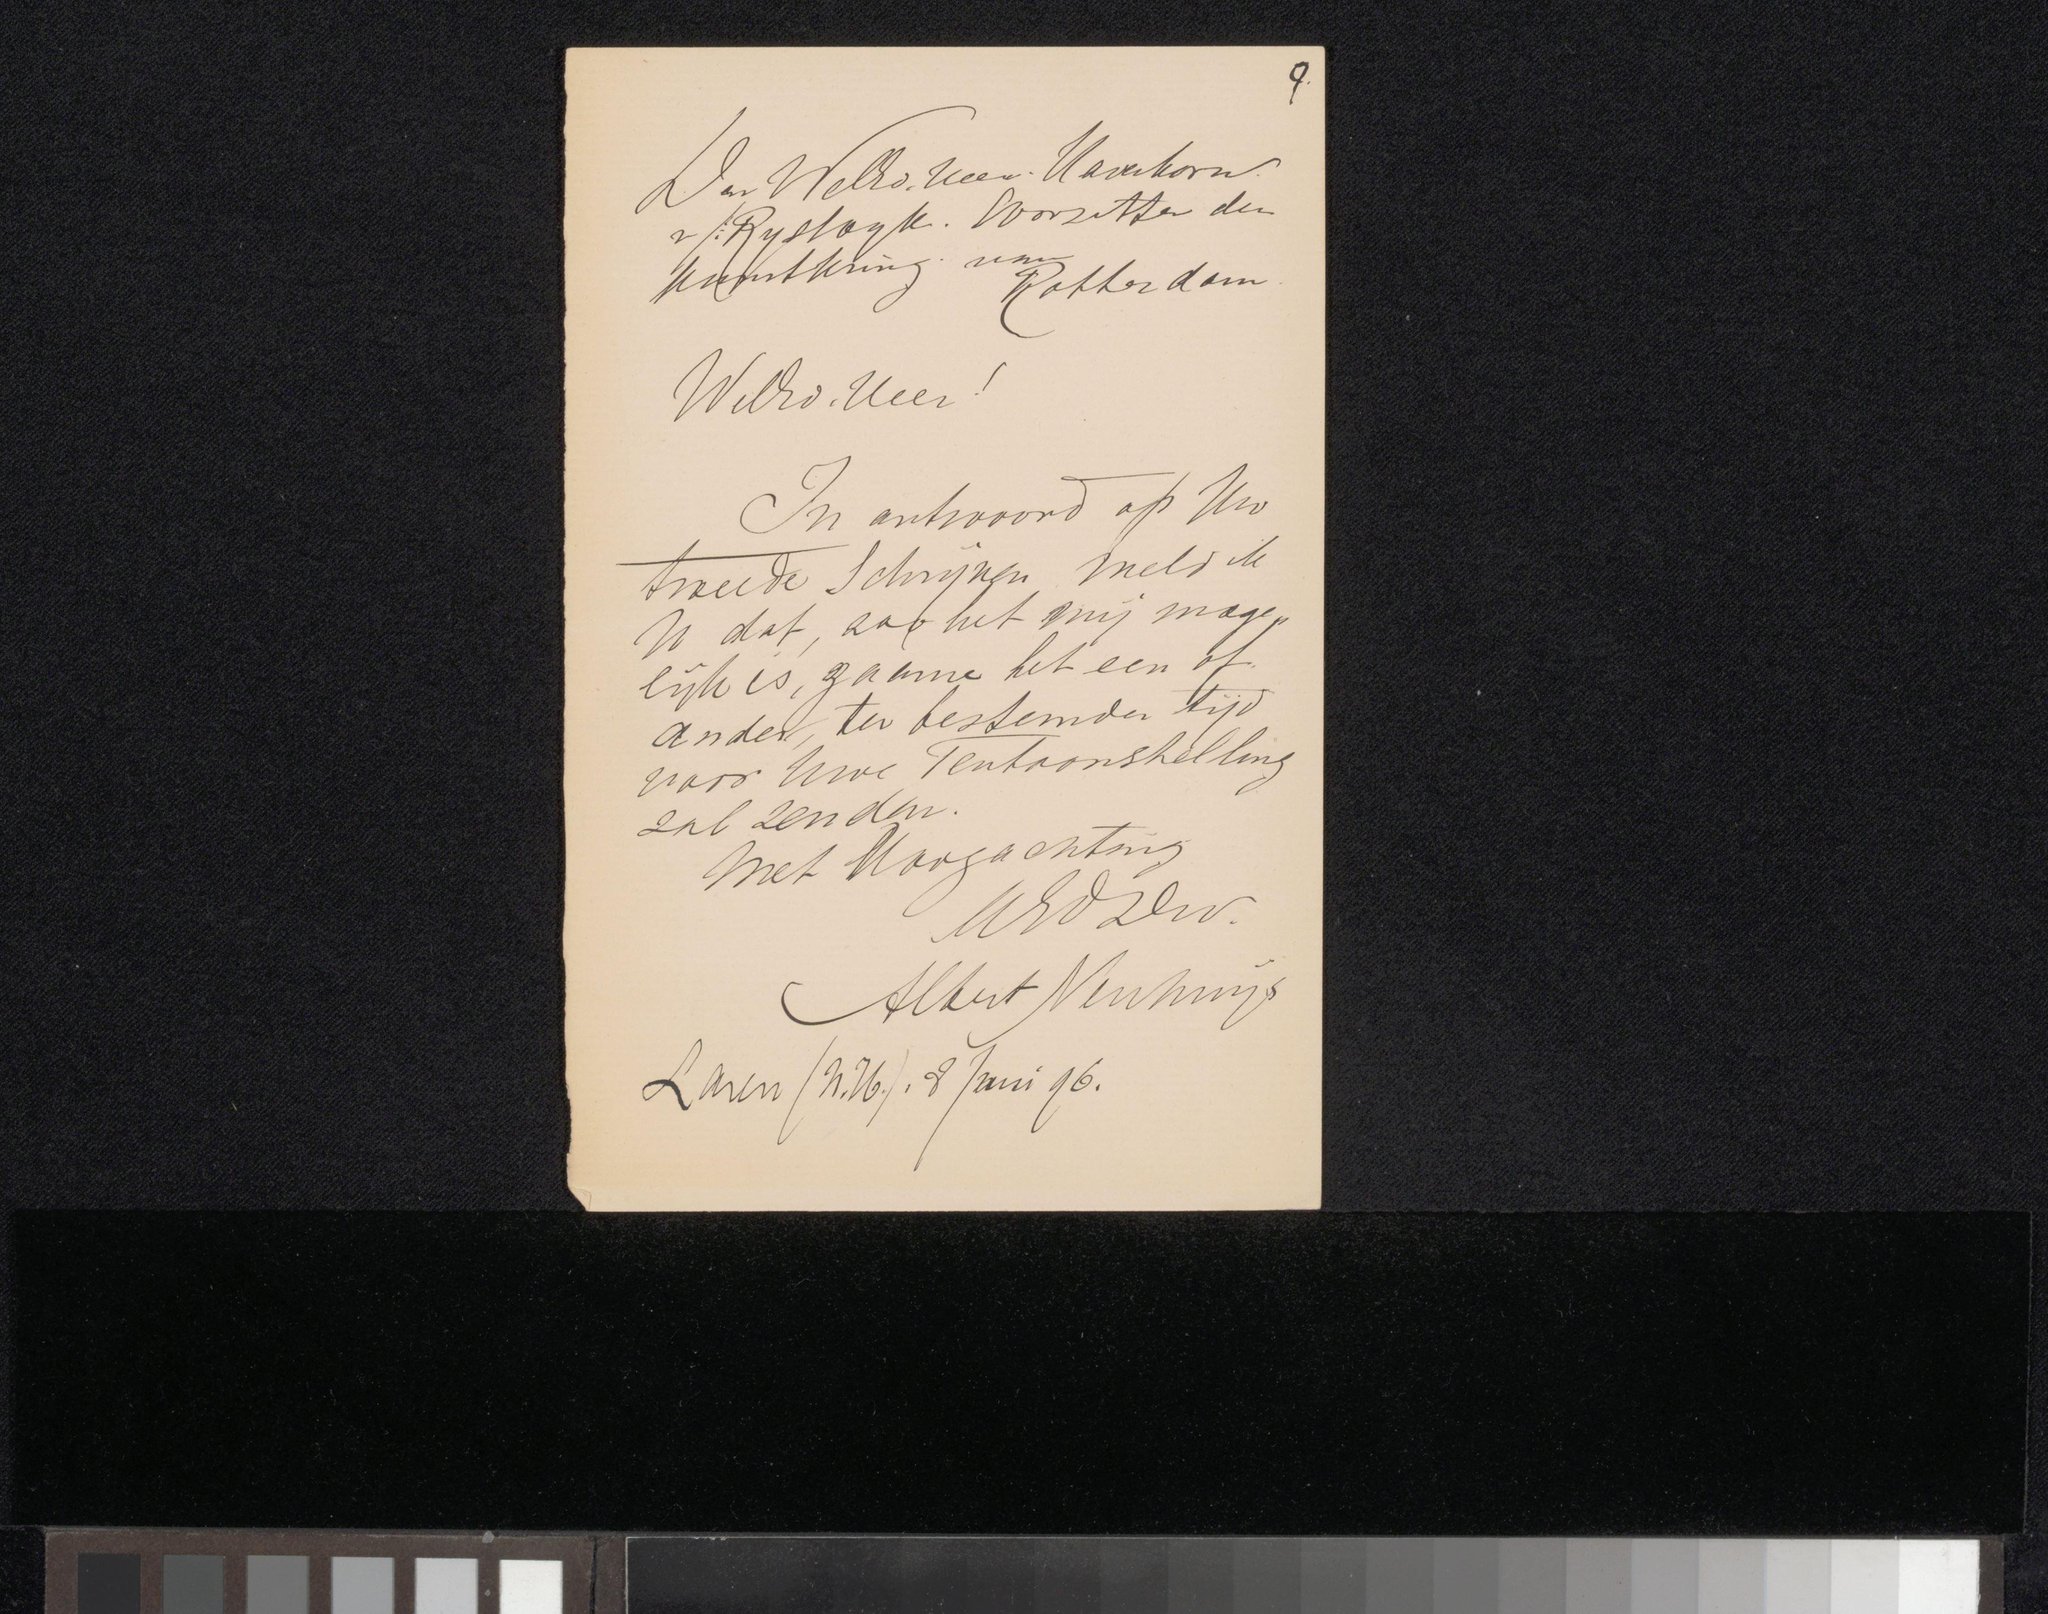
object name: letter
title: Brief aan Pieter Haverkorn van Rijsewijk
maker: albert neuhuys (1844-1914)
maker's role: draughtsman, painter, print maker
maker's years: 1844-1914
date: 1896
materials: ink, paper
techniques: pen, writing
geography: laren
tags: pieter haverkorn van rijsewijk, exhibition ~ art